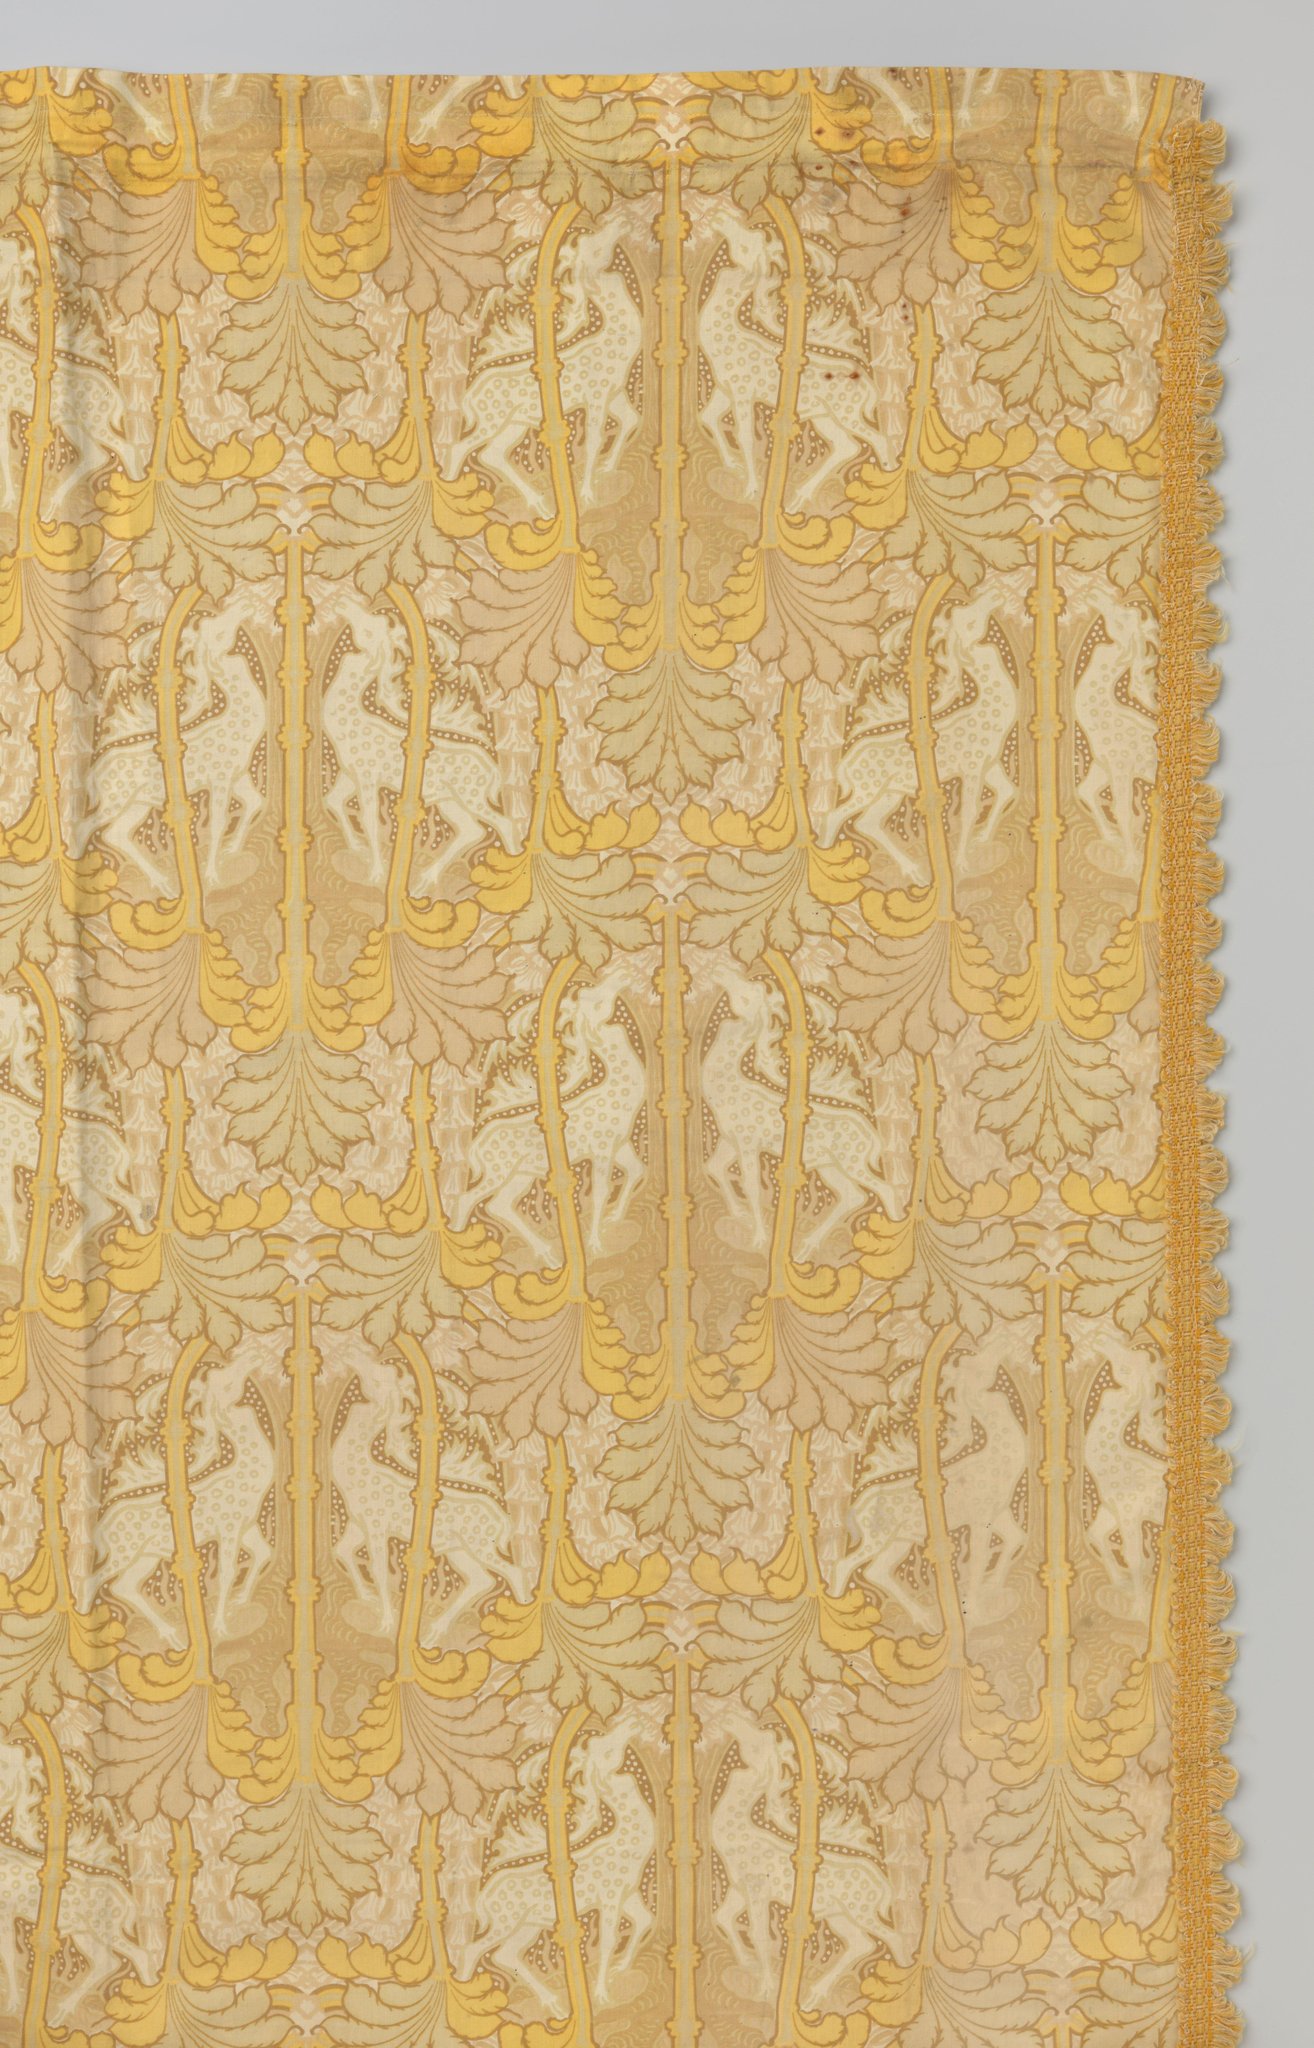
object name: overgordijn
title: Overgordijn van bedrukte cretonne met herten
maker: michiel duco crop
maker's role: designer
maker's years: 1862-1901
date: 1900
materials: linen, metal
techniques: printing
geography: helmond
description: Overgordijn van bedrukte cretonne met herten in gele en zachtbruine tinten op naturelkleurig fond. Aan de binnenzijde afgeboord met passement.